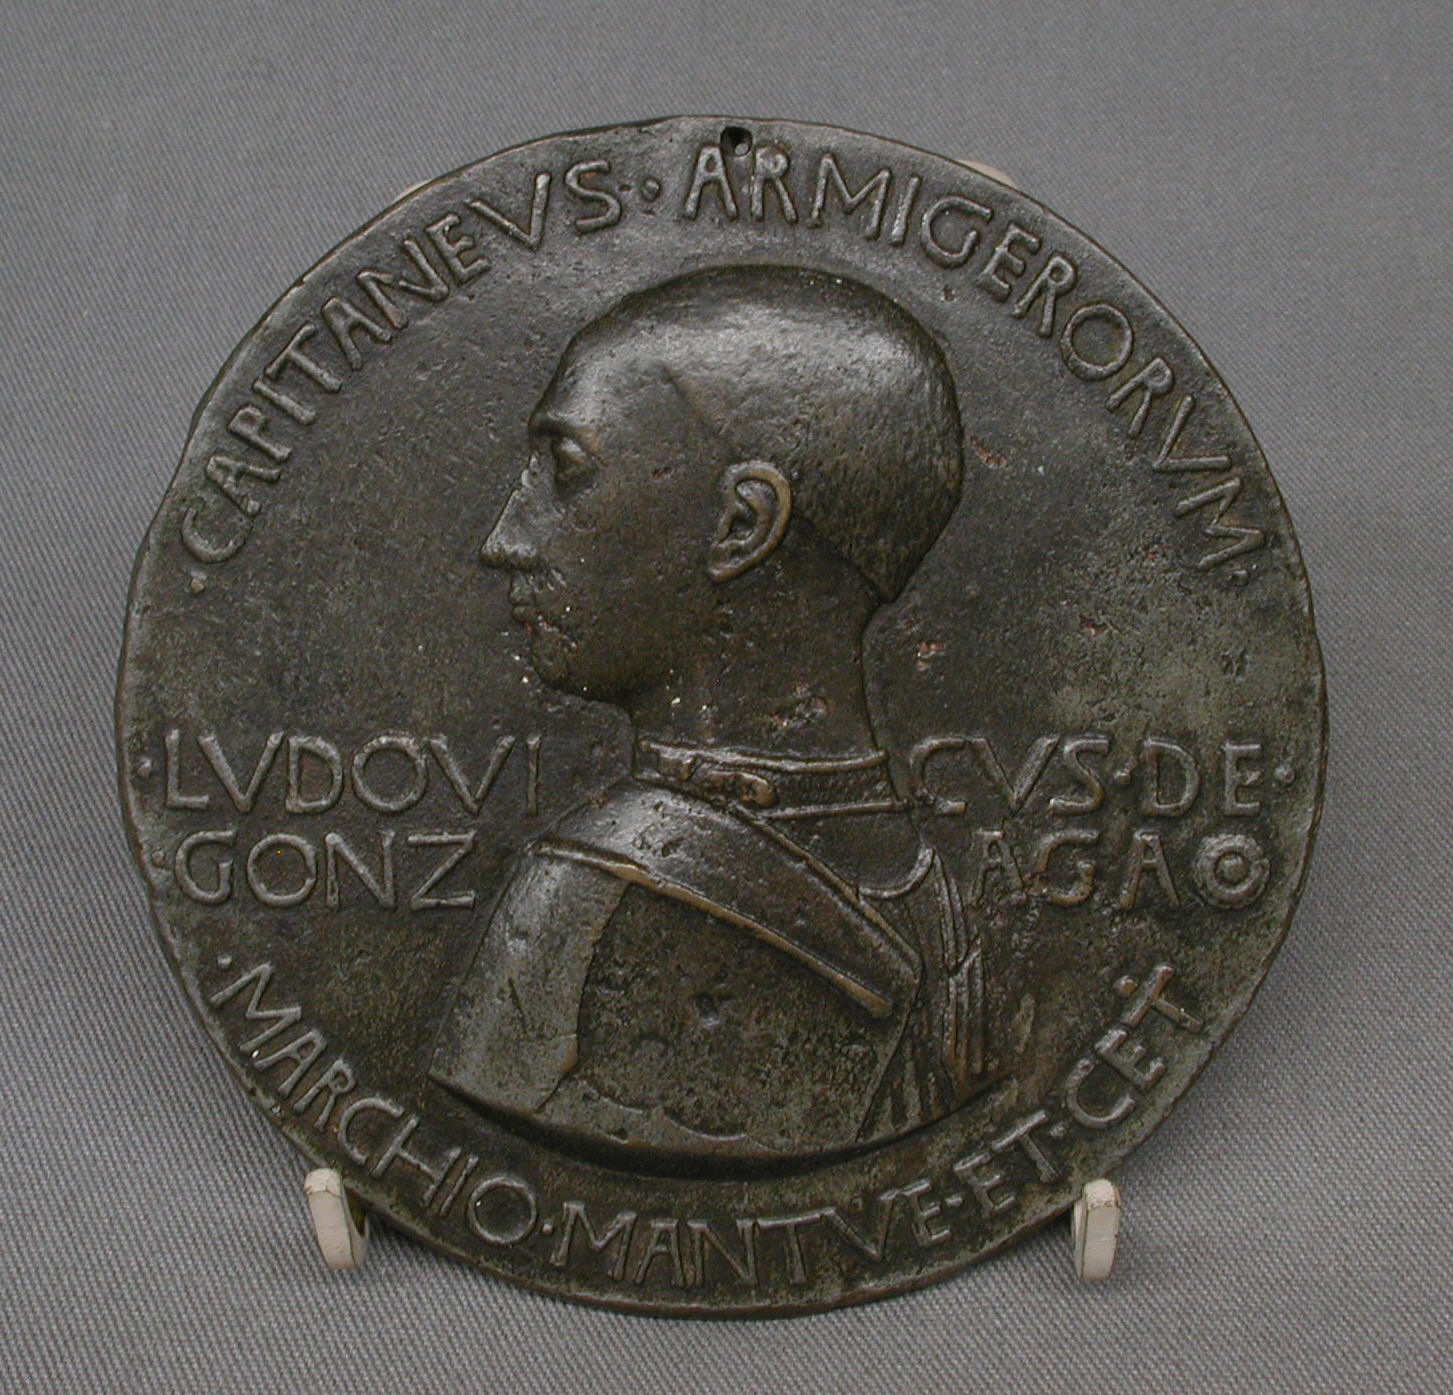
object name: medal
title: Ludovico Gonzaga III (1414–1478)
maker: pisanello (antonio pisano)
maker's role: artist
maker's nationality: italian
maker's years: 1395-1455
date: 1447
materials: bronze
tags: men,horses